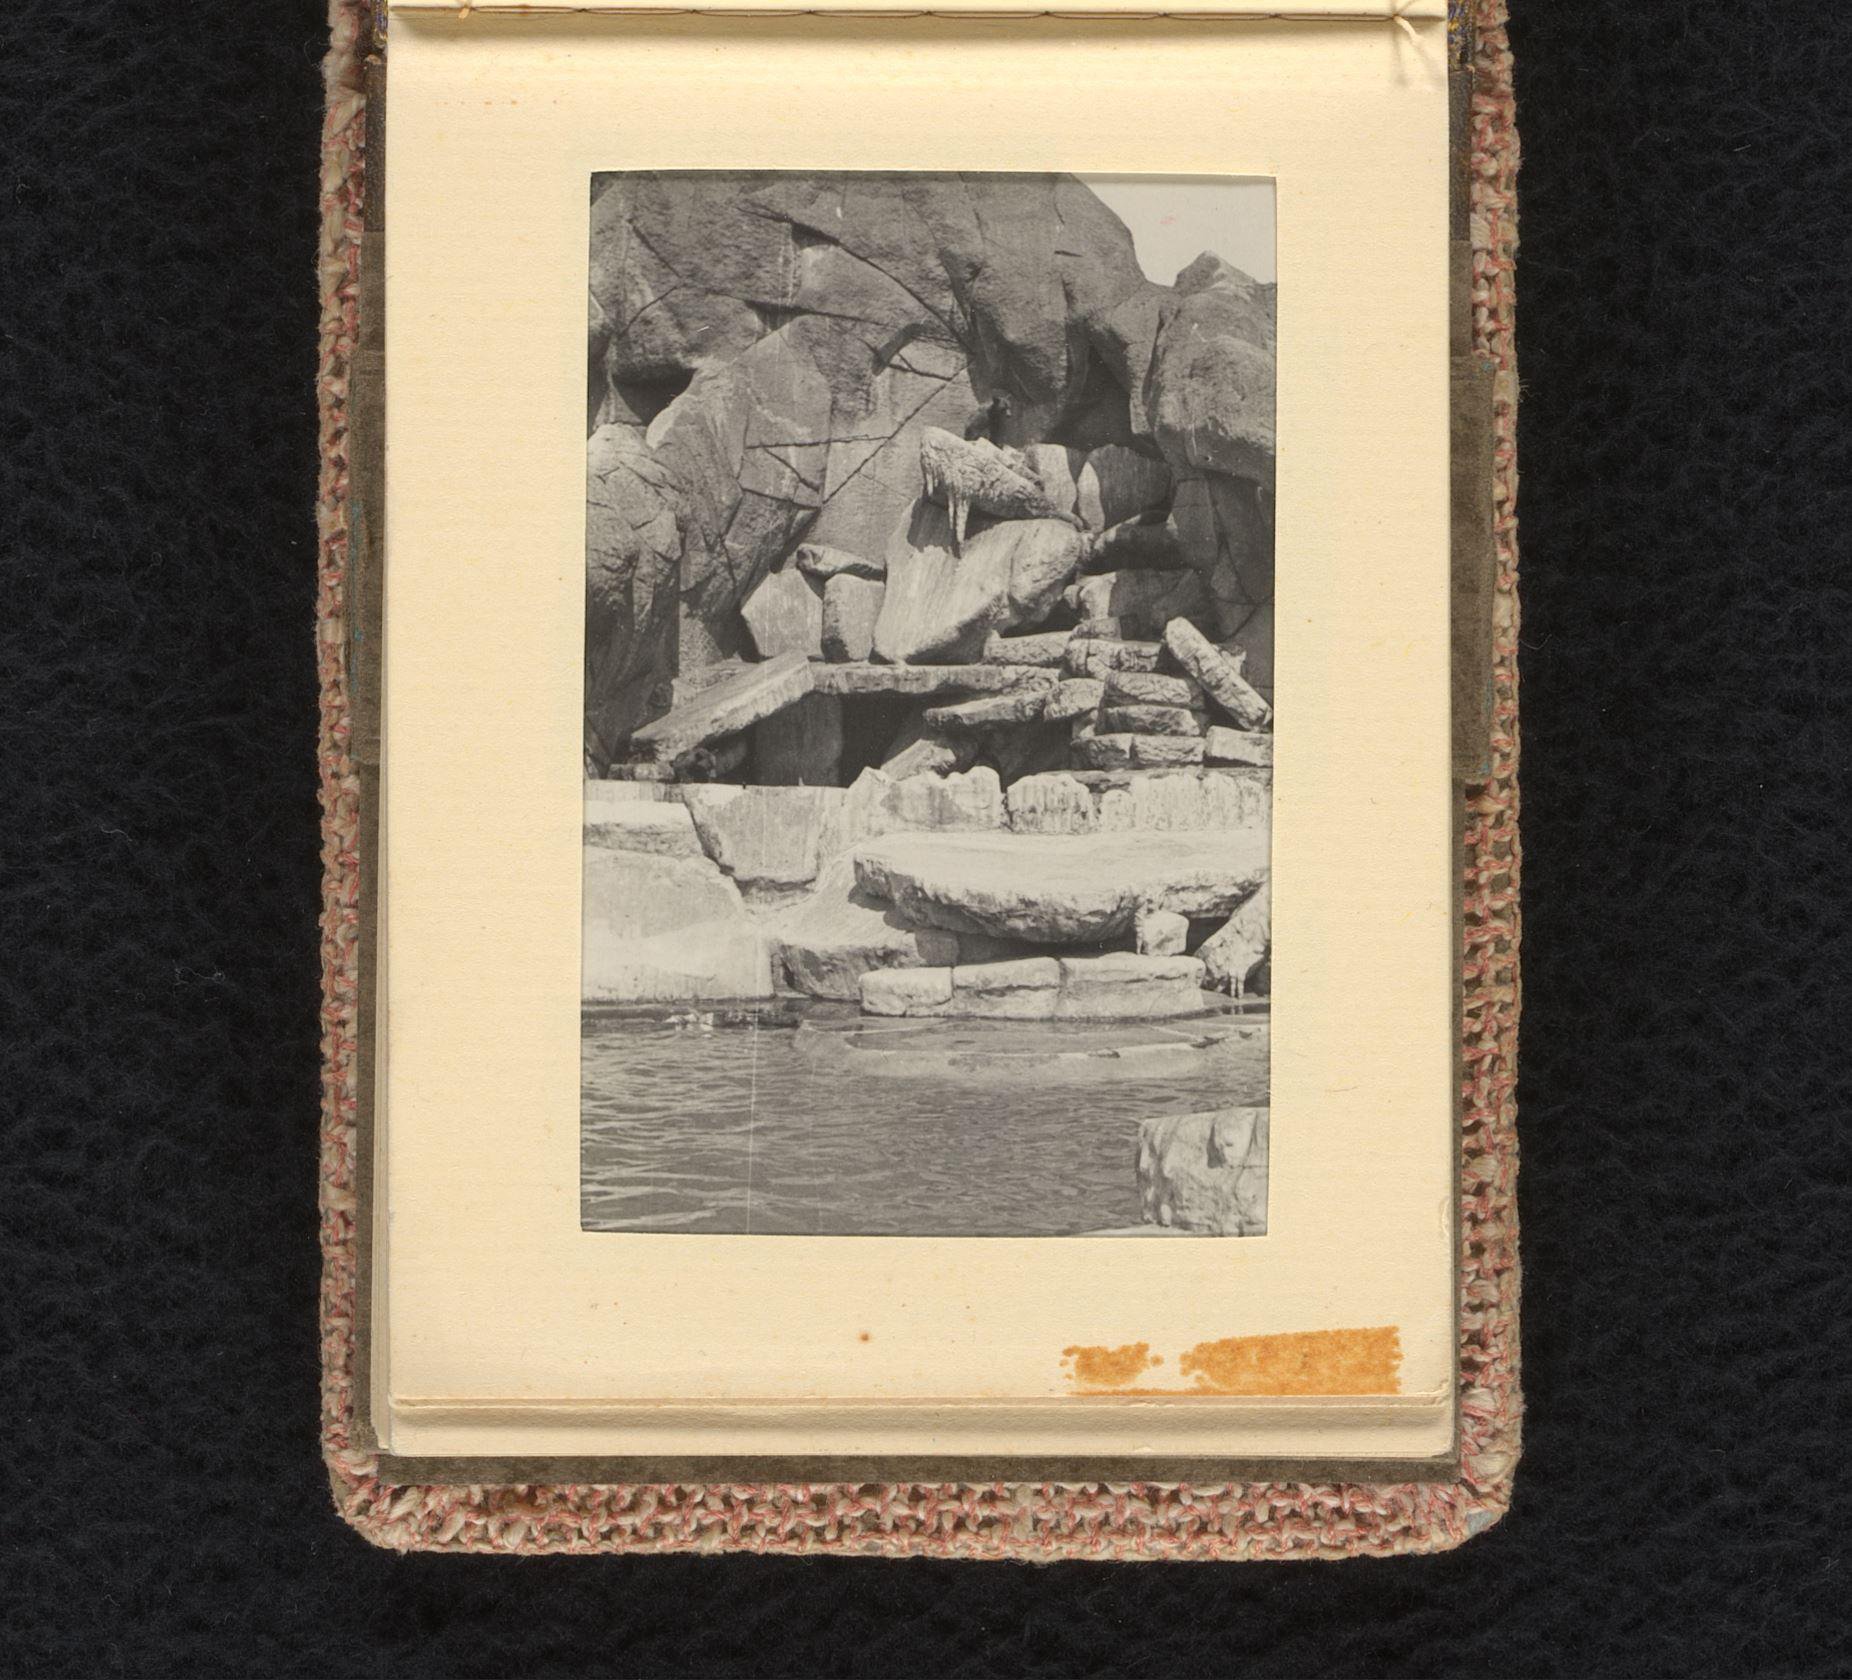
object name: photograph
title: Dierenverblijf zonder dieren in de dierentuin, juli-augustus 1933, Hamburg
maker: else wachenheimer-moos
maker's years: 1895-1944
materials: paper, photographic support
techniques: gelatin silver print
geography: hamburg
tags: the family travelling, on holiday, zoo (as place of recreation)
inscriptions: date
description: Albumblad met een foto. Onderdeel van het fotoalbum Hamburg zomer 1933.